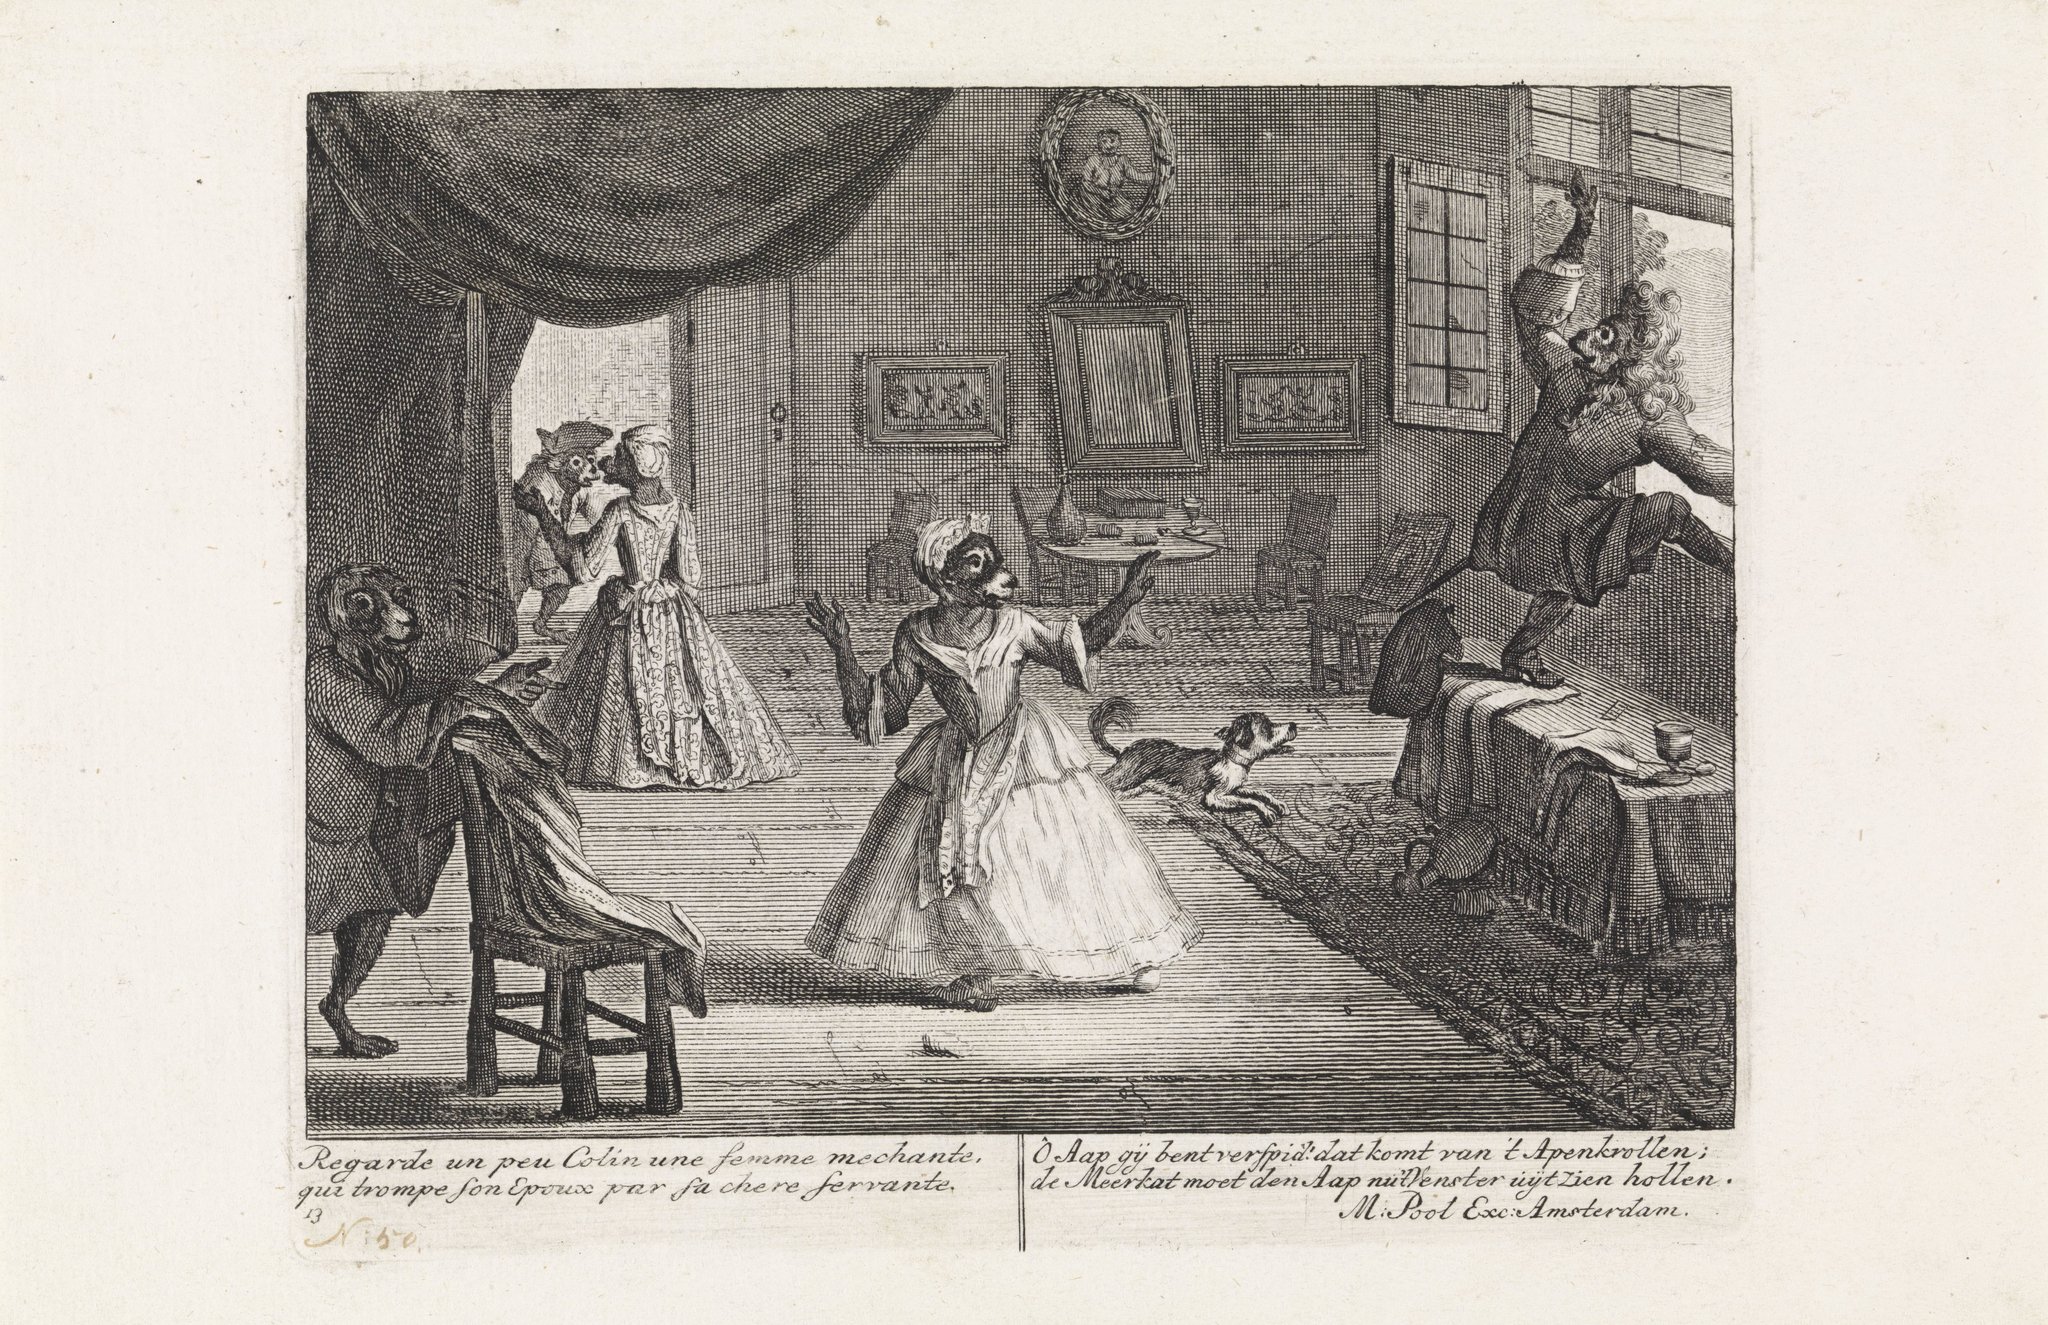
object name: print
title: Aap als betrapte minnaar, ca. 1720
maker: matthijs pool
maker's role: print maker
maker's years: 1676-1740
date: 1720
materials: paper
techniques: engraving, etching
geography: amsterdam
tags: monkeys, apes, animals acting as human beings, mistress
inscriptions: collector's mark: Lugt 2228, number: ‘N. 50’, collector's mark: Lugt 2760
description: Een aap vlucht als betrapte minnaar uit een raam wanneer de echtgenoot thuiskomt. In het onderschrift versjes in het Frans en Nederlands. Prent nr. 13 in een serie van 16 prenten van ca. 1720 waarin apen als mensen figureren in allerlei huishoudelijke taferelen.